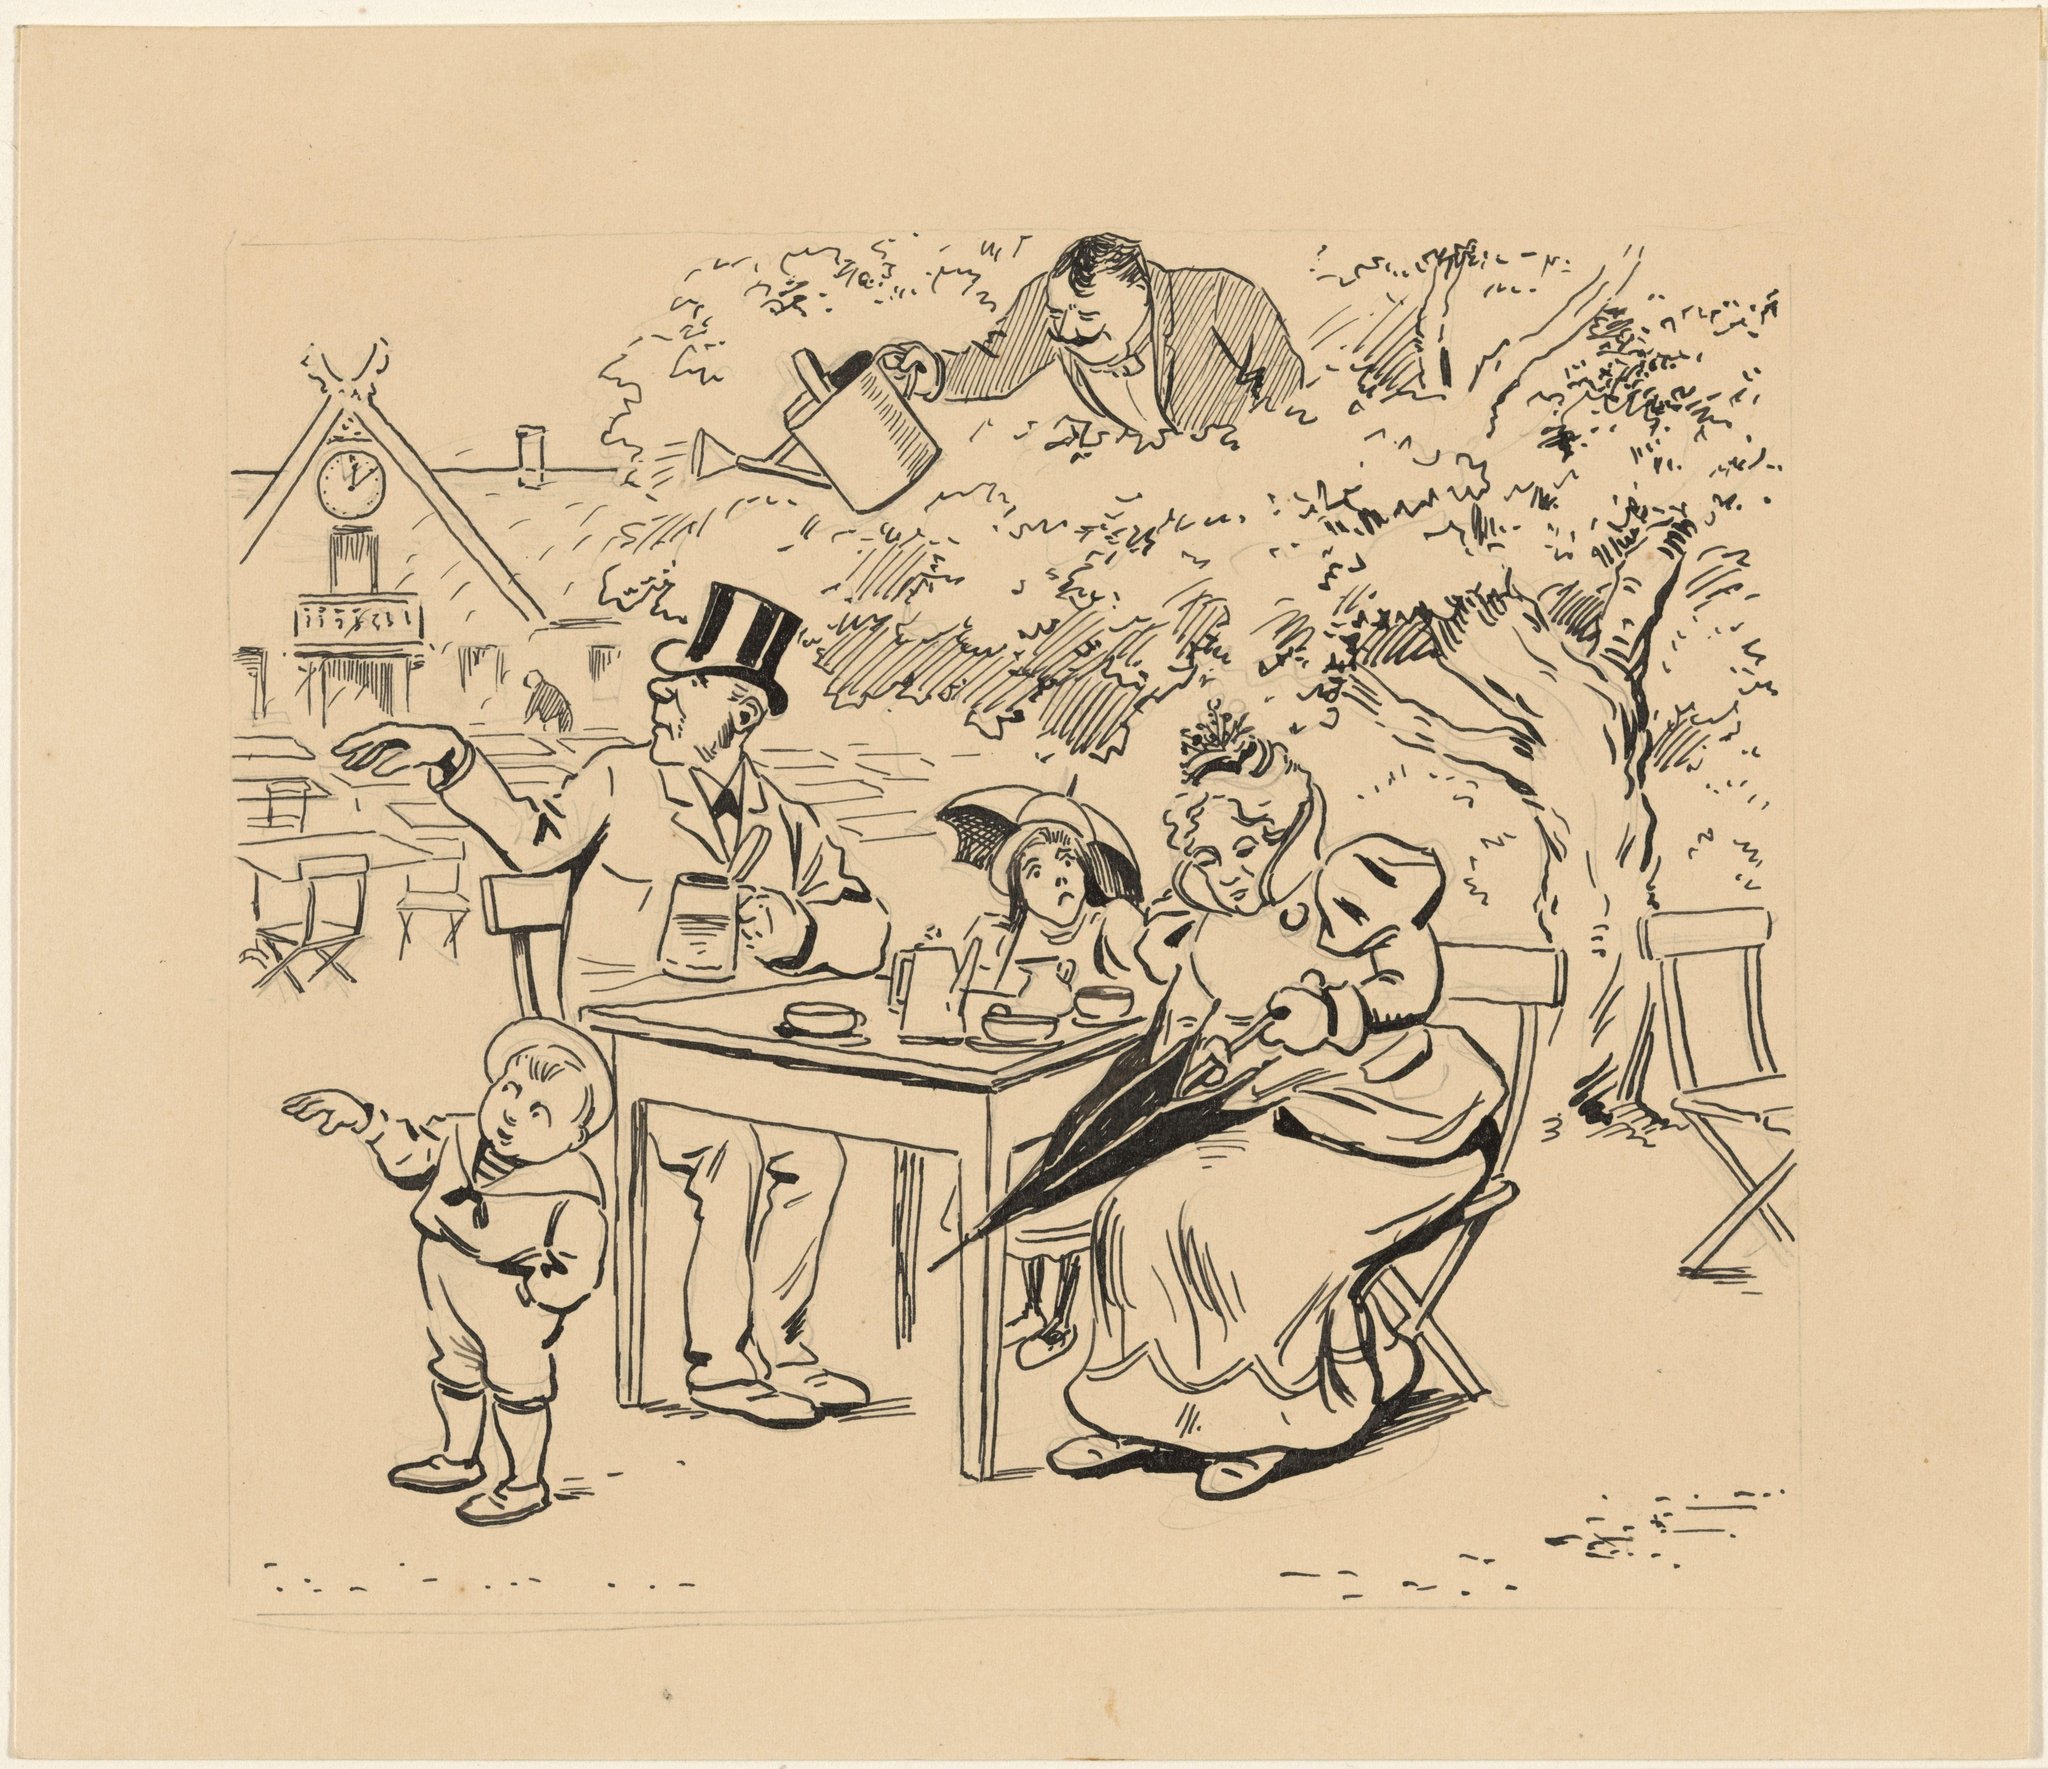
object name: drawing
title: Regen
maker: axel thies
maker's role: draughtsman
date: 1850-1907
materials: ink, paper, pencil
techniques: brush, pen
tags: rain, pavement, terrace in front of inn or restaurant, outing, pleasure trip, (family) meal - cc - out of doors